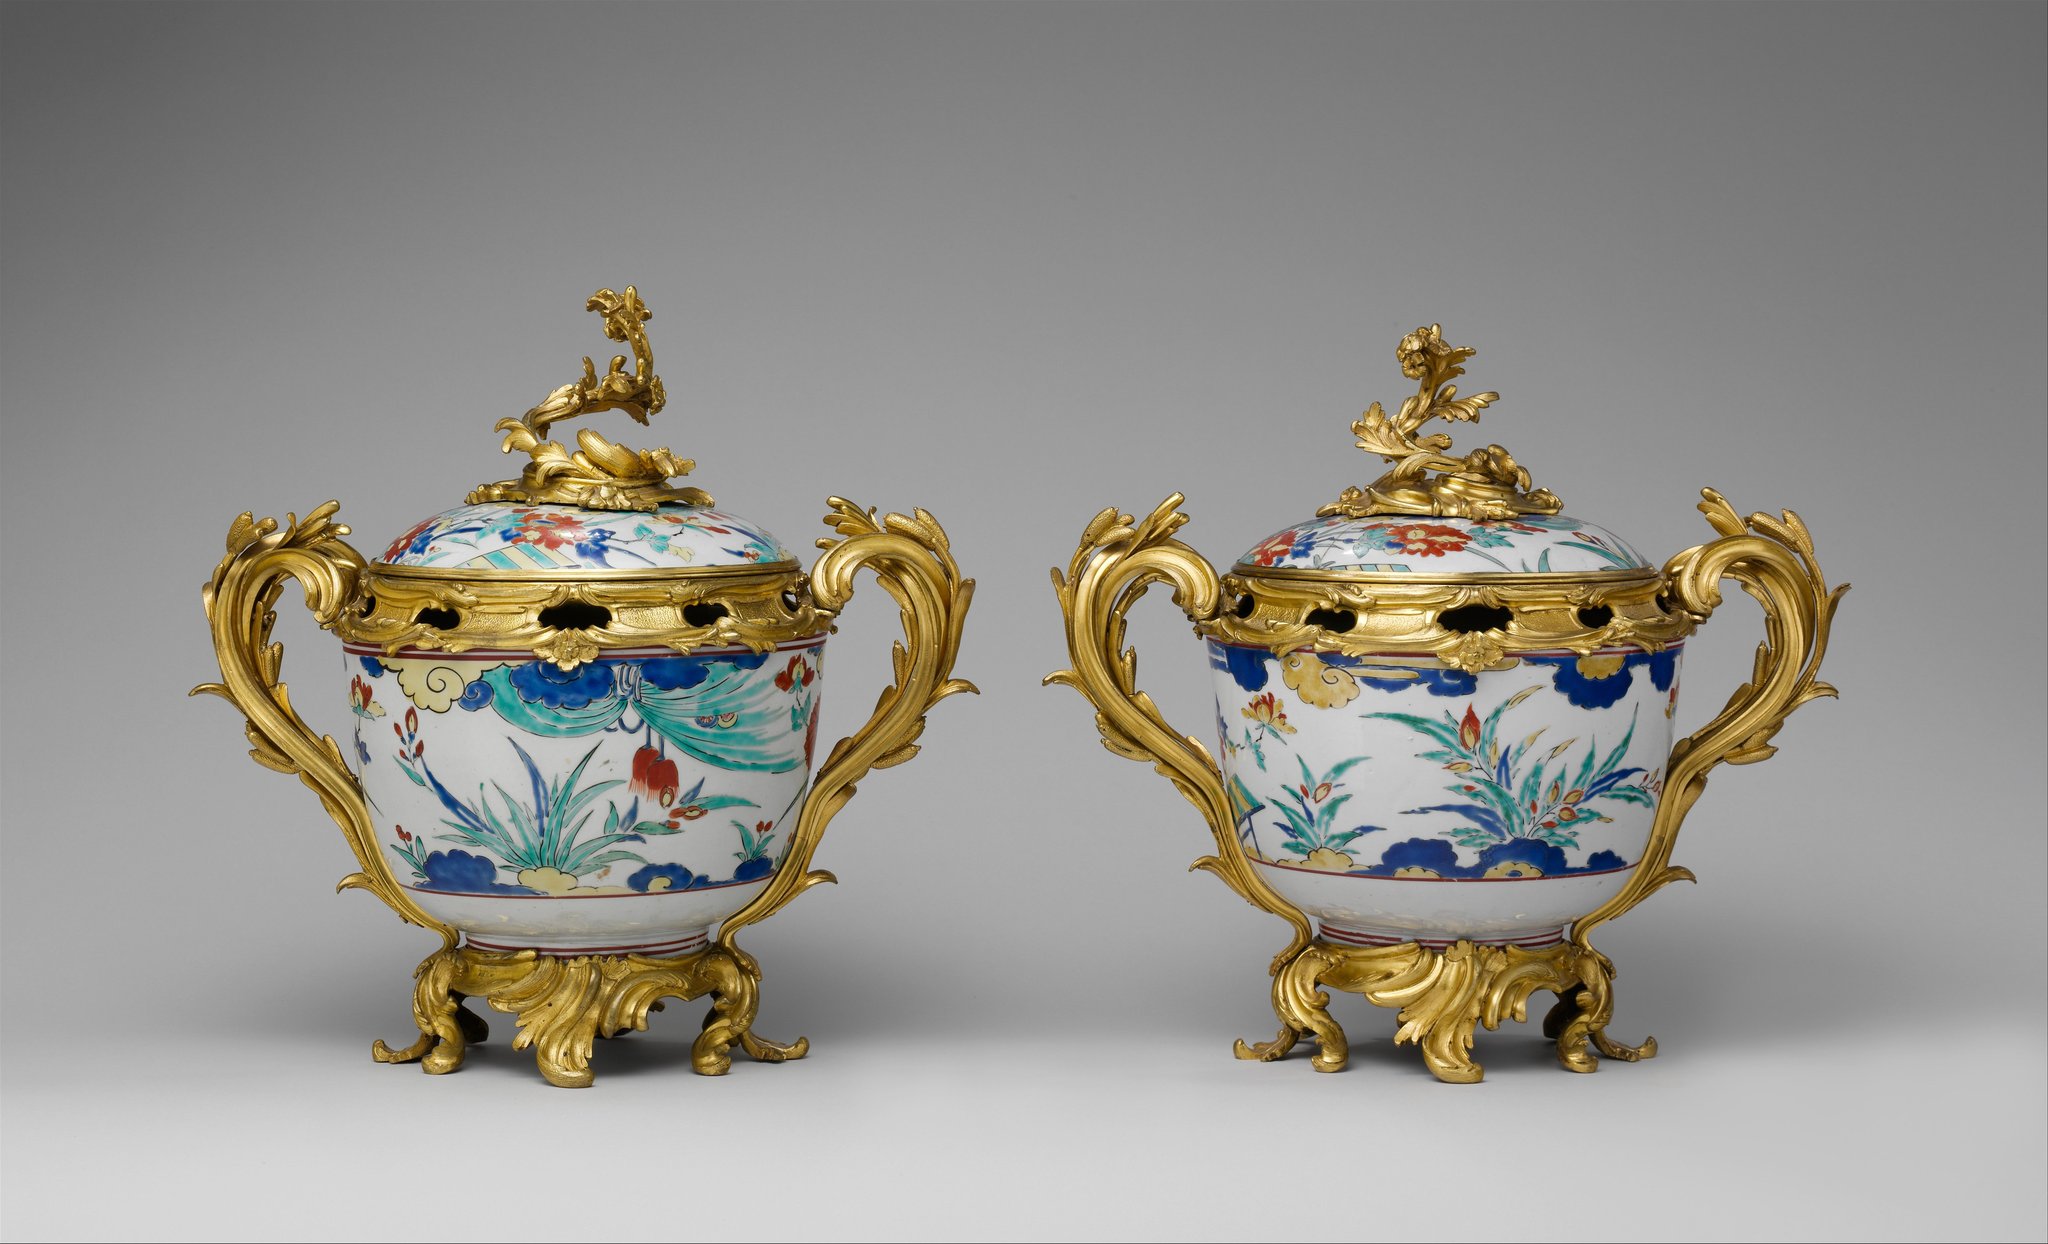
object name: potpourri bowl with cover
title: Potpourri bowl with cover (one of a pair)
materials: gilt bronze, hard paste porcelain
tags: flowers